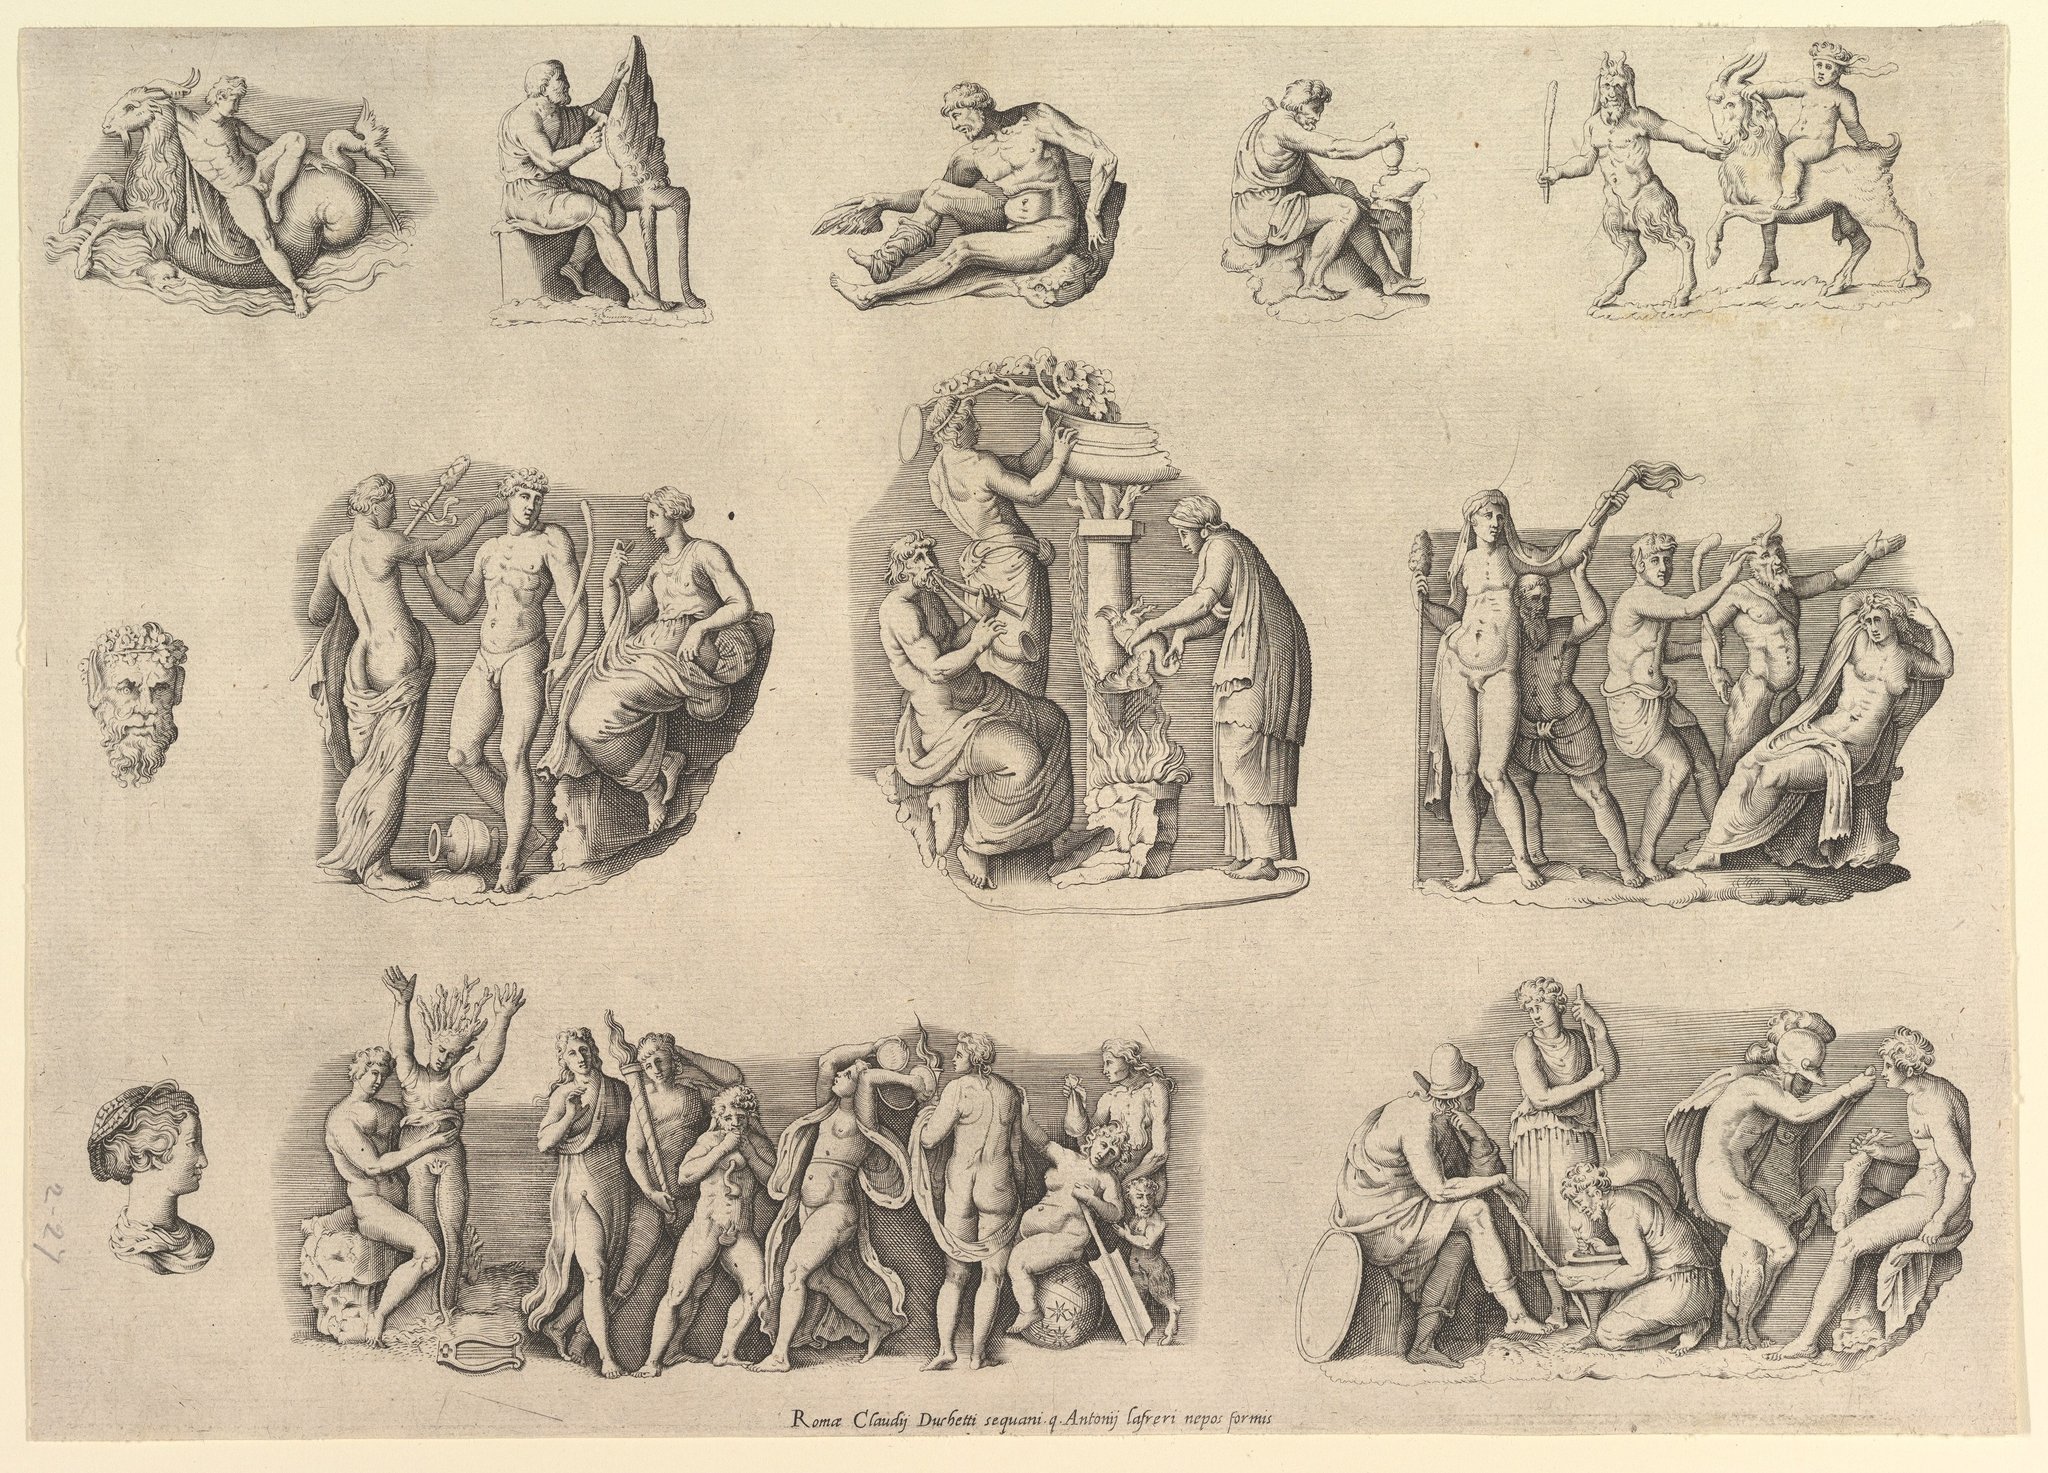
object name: print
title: Subjects after Antique Cameos and Gems, from "Speculum Romanae Magnificentiae"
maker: anonymous, italian, 16th century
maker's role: artist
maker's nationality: italian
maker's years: 1500-1600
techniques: engraving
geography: rome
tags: male nudes,female nudes,satyrs